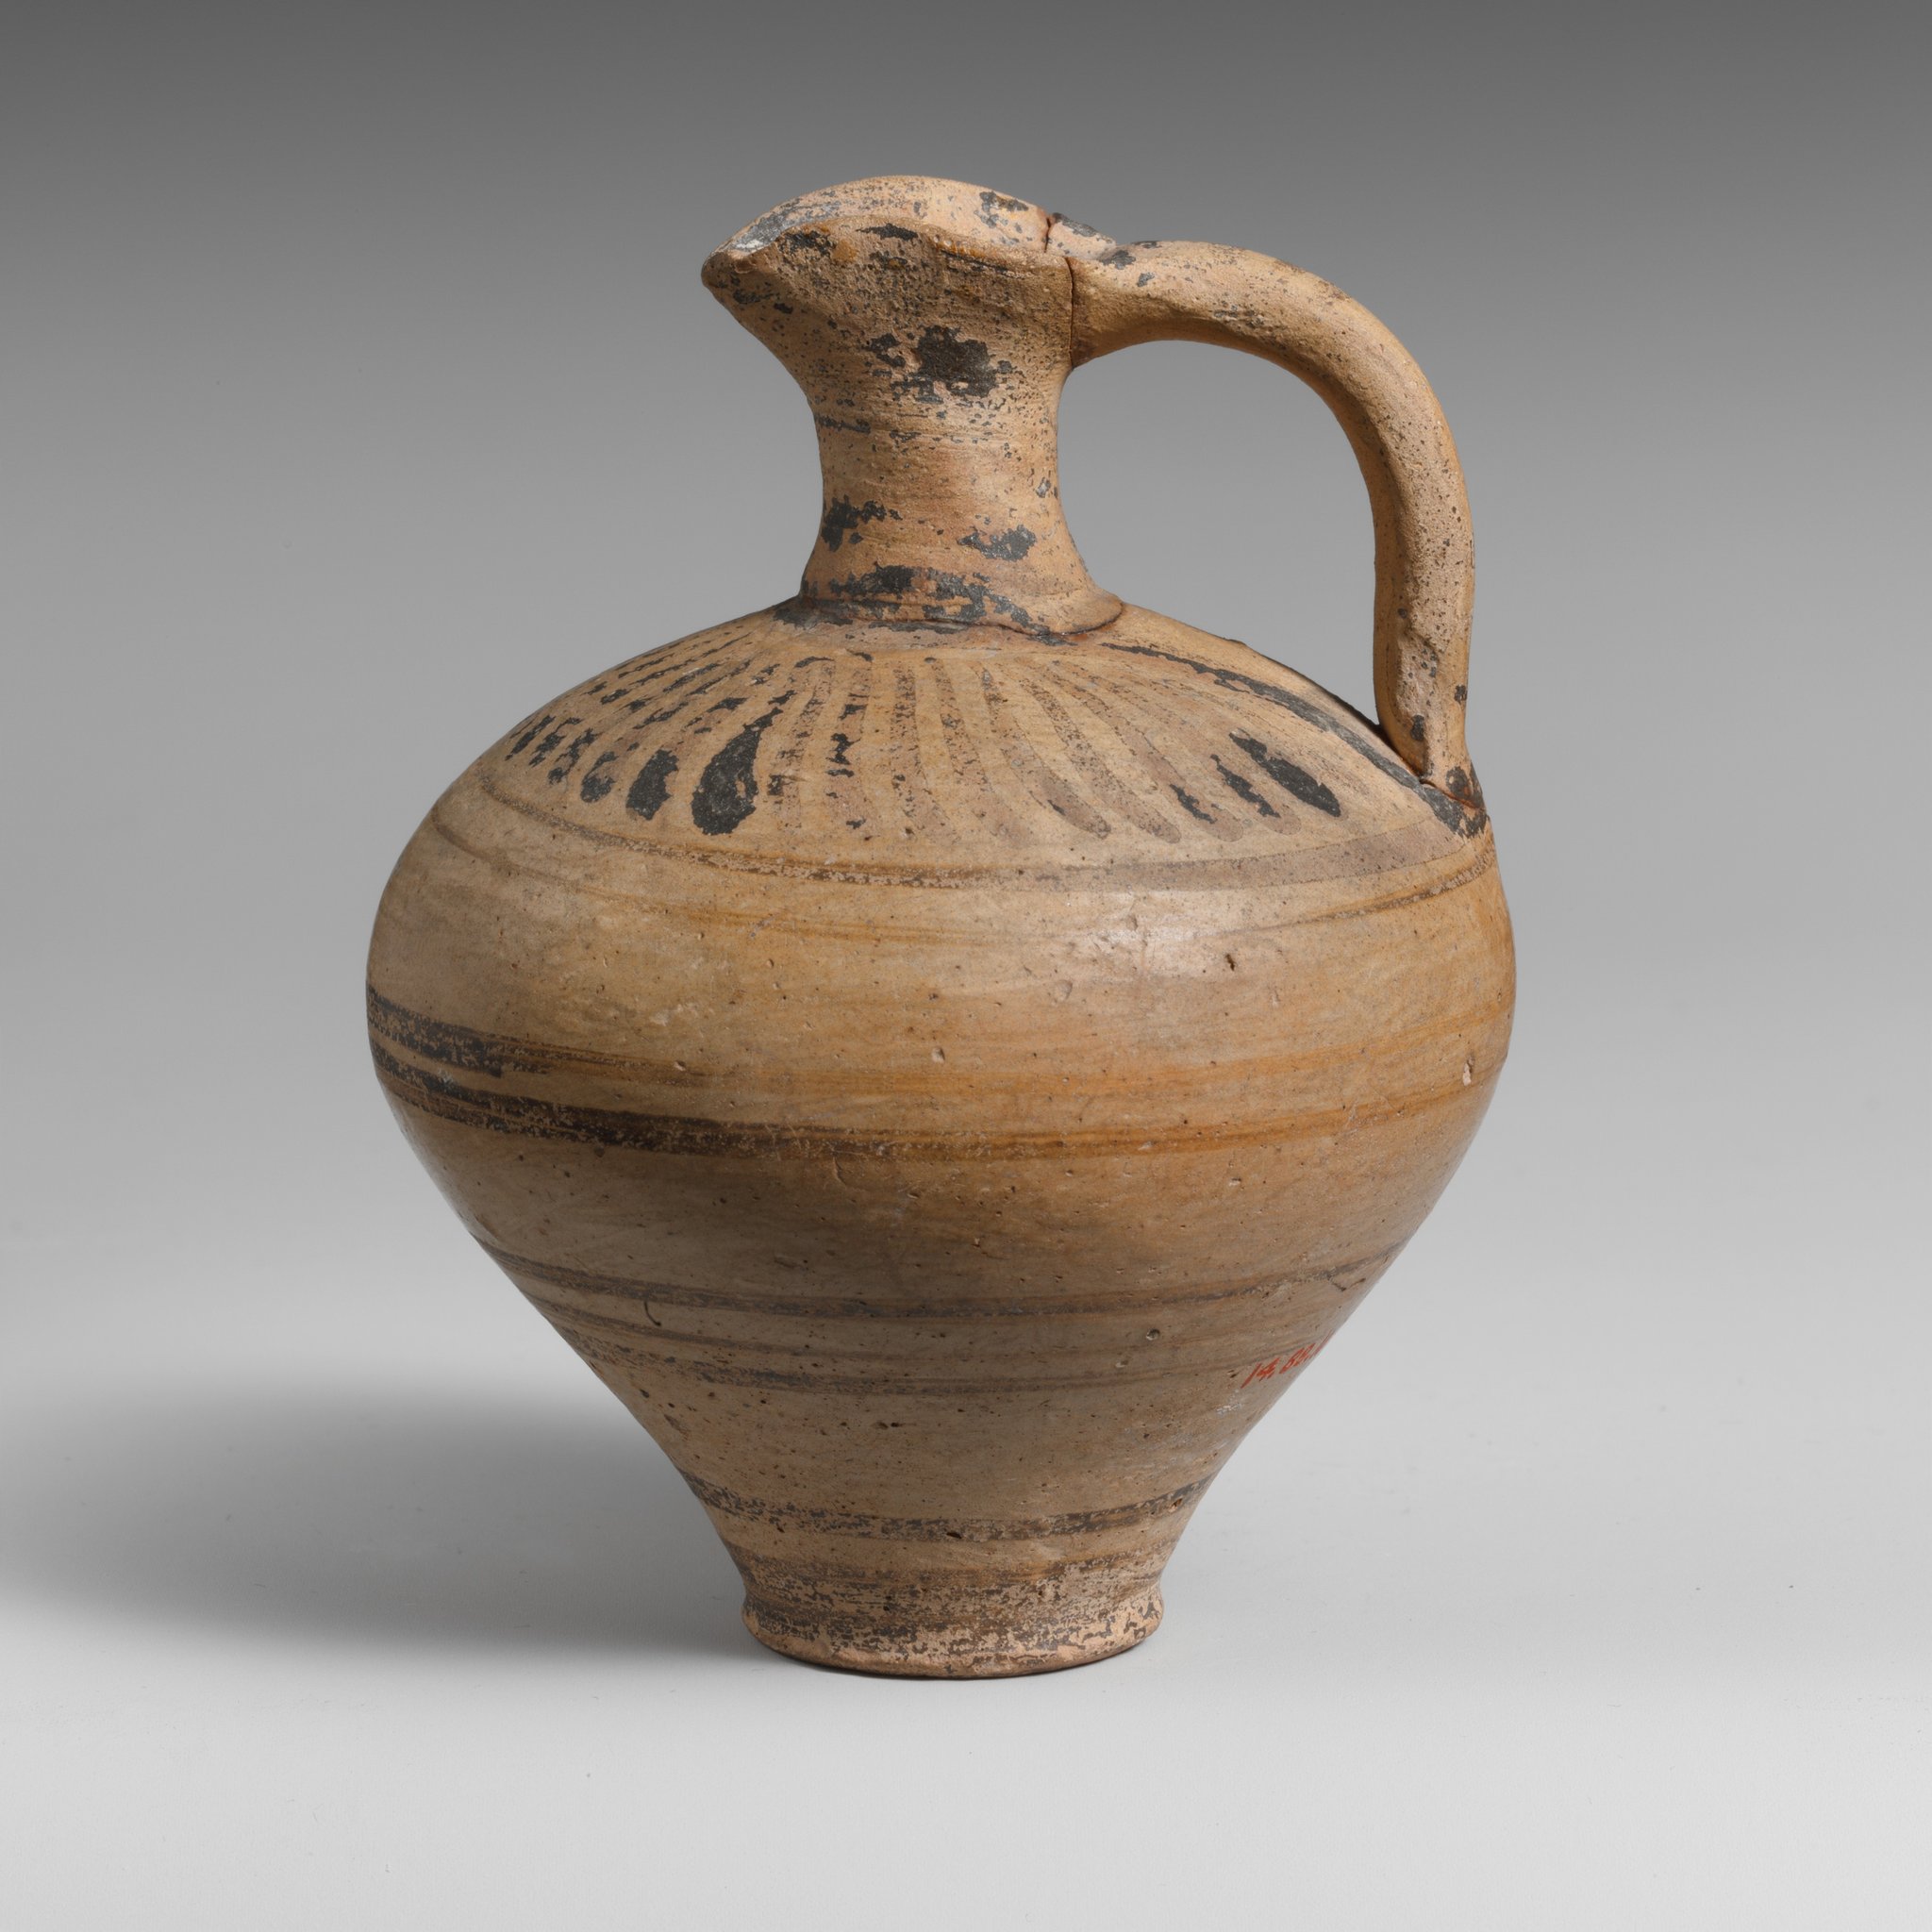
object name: jar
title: Terracotta juglet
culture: minoan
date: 1375-1300 BCE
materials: terracotta